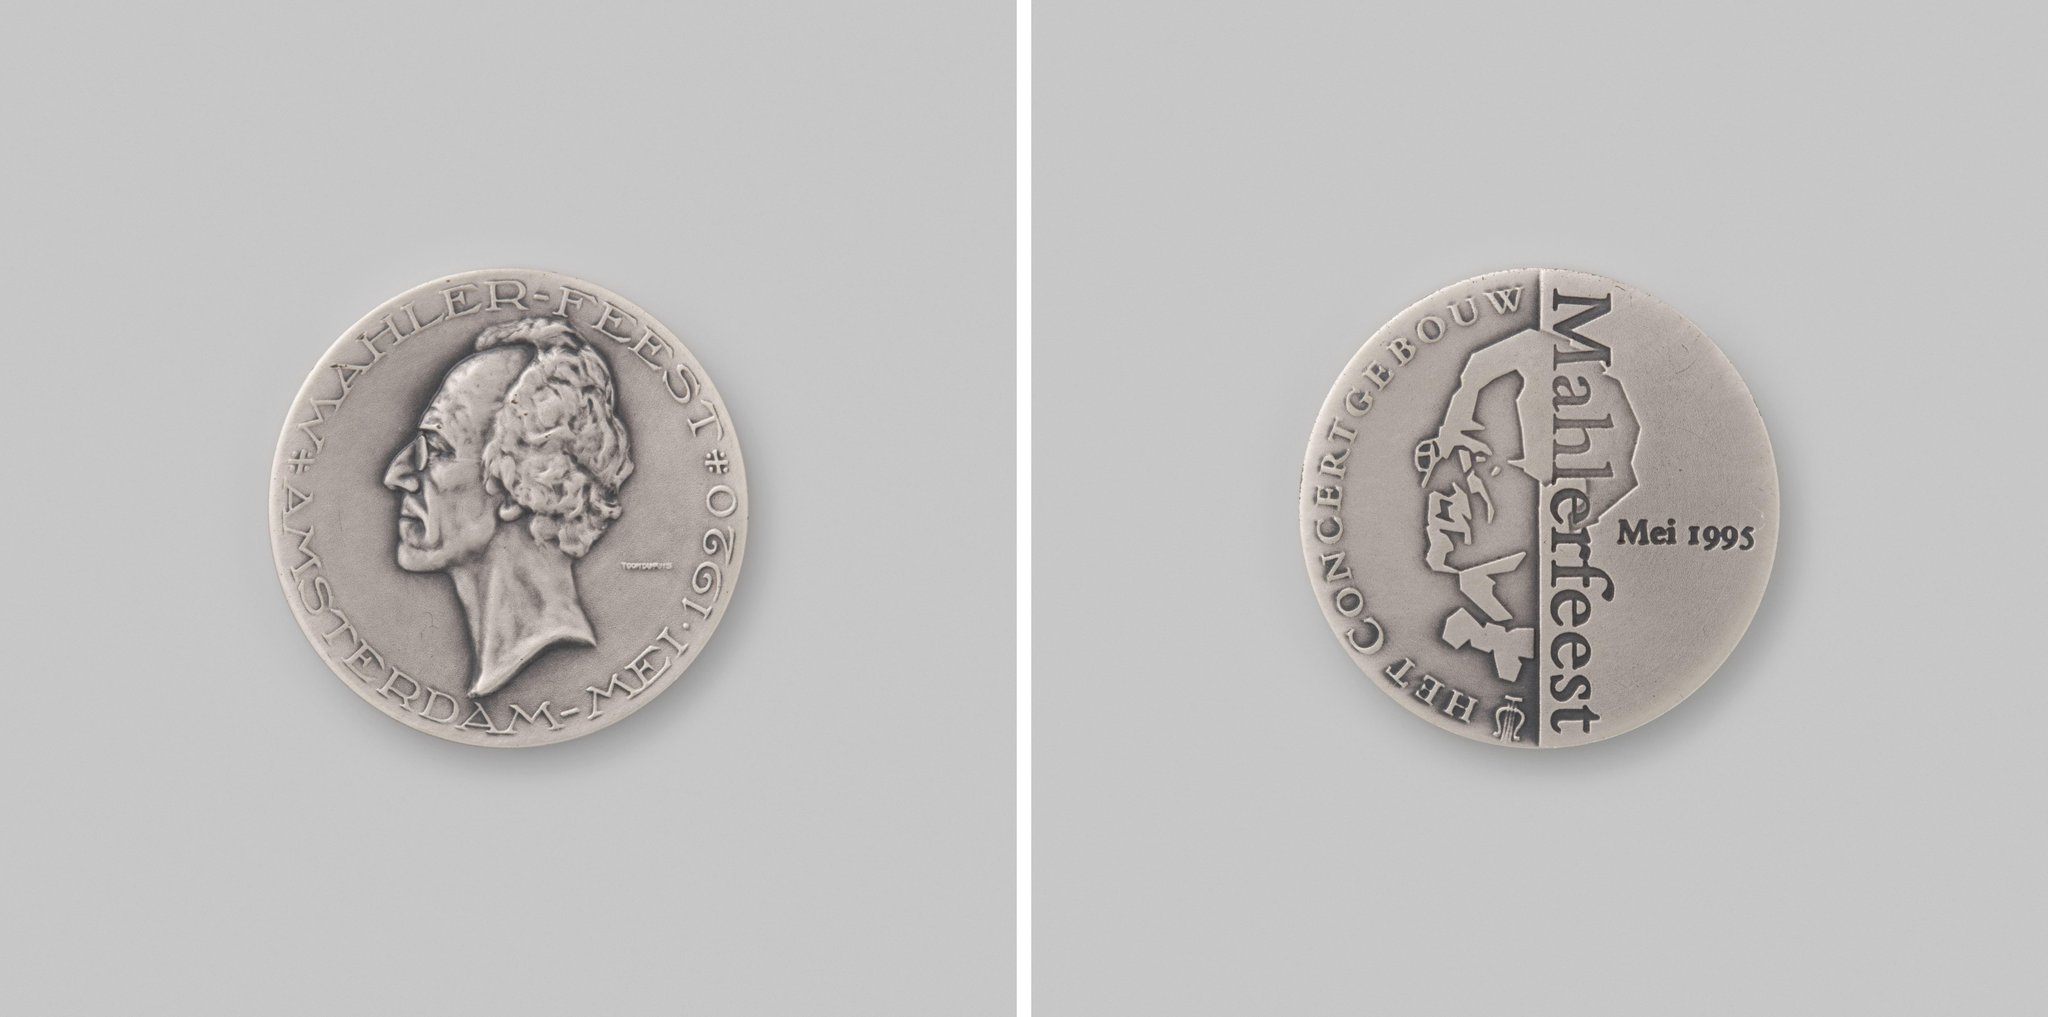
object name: medal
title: Mahler feest Amsterdam, 1995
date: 1995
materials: plastic, silver, velvet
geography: netherlands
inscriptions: inscription: ‘Mahlerfeest / Mei 1995 / HET CONCERTGEBOUW’, inscription: ‘Mahlerfeest’, circumscription: ‘MAHLER - FEEST * AMSTERDAM - MEI 1920 *’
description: Zilveren penning geslagen ter ere van het Mahler feest, gehouden te Amsterdam mei 1995 in het Concertgebouw. Voorzijde: man met profiel naar links met omschrift. Keerzijde: modern ontwerp met opschrift. In plastic blauw doosje met opschrift, binnenzijde blauw fluweel. Met zilvercertificaat. Met bijbehorende doos NG-2001-17-P-2.